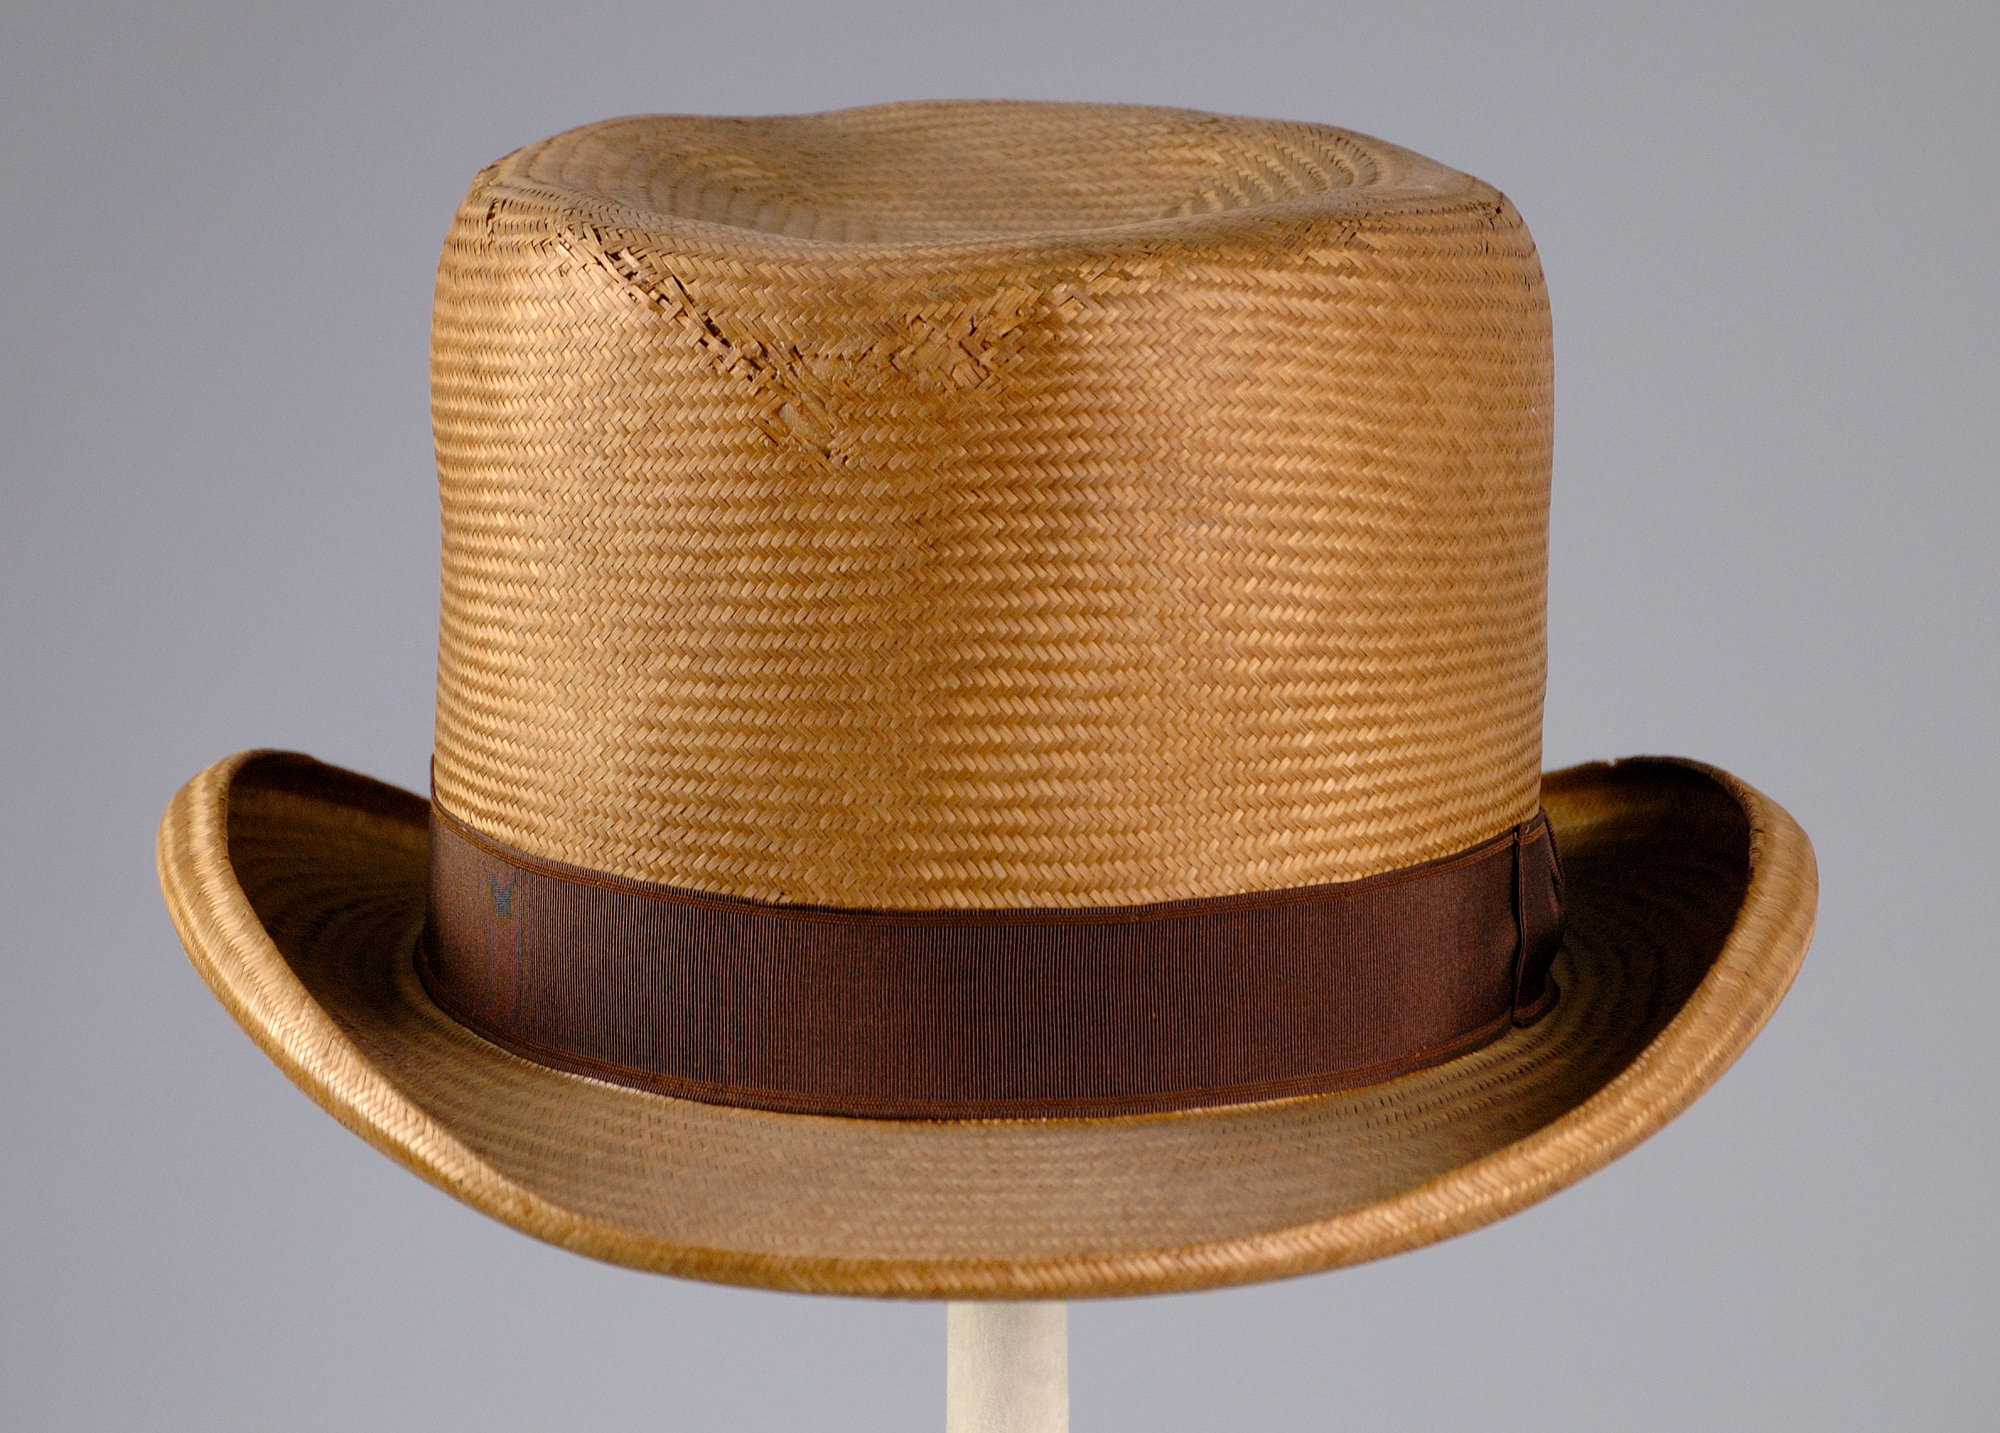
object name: hat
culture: american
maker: pemberton-mercer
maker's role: maker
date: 1870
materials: silk, fiber